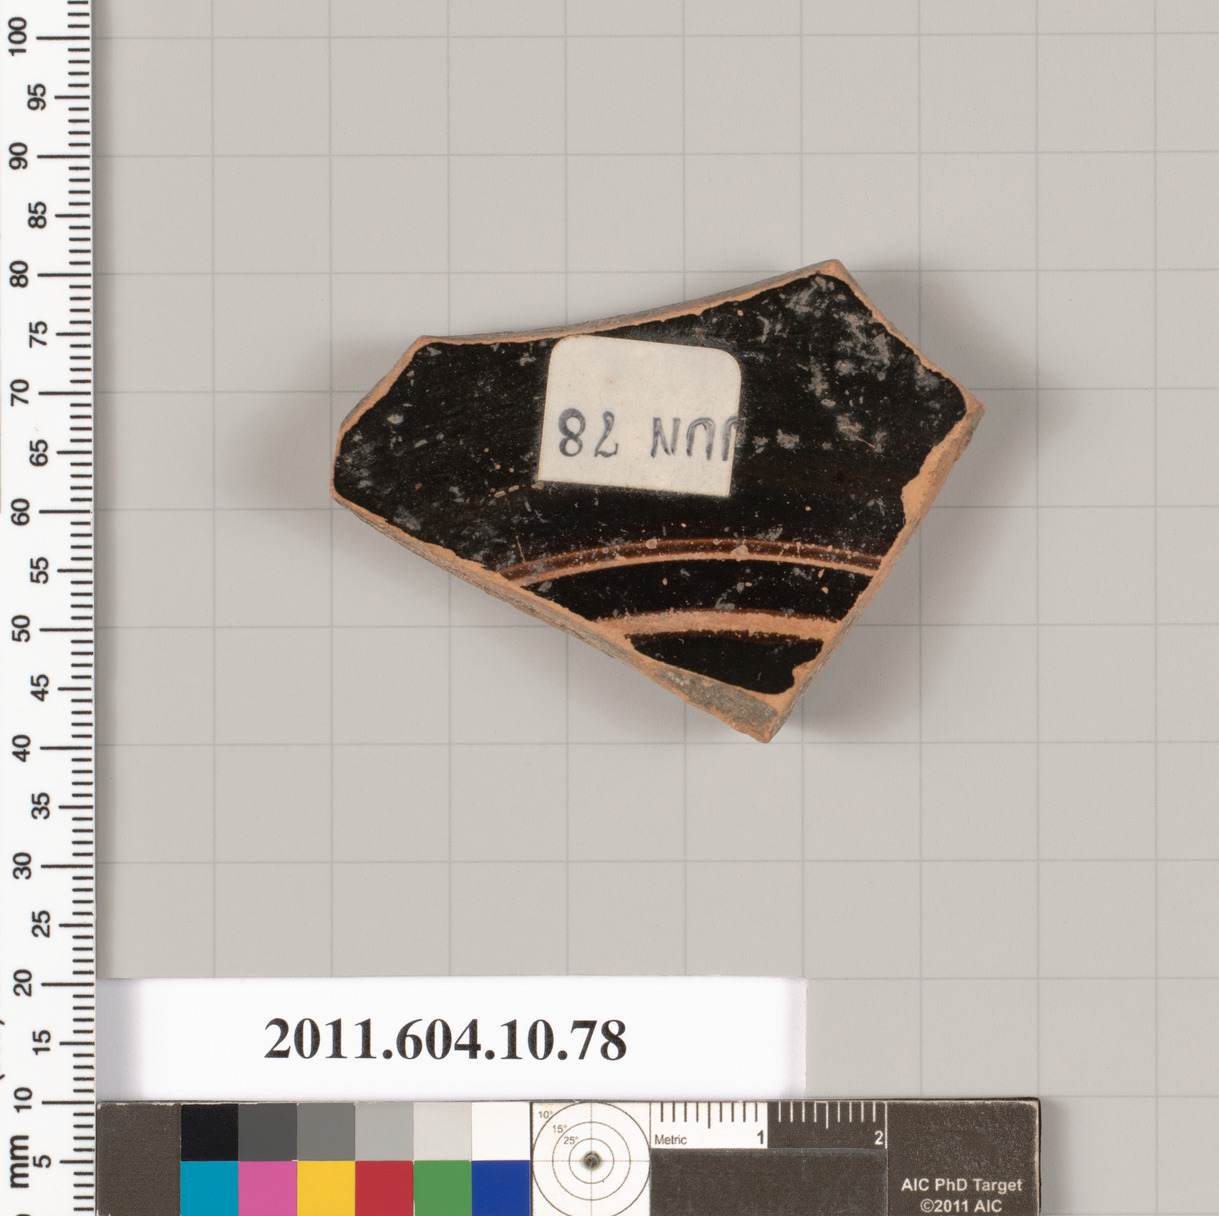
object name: fragment of a bowl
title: Terracotta fragment of a bowl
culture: etruscan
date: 400-301 BCE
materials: terracotta